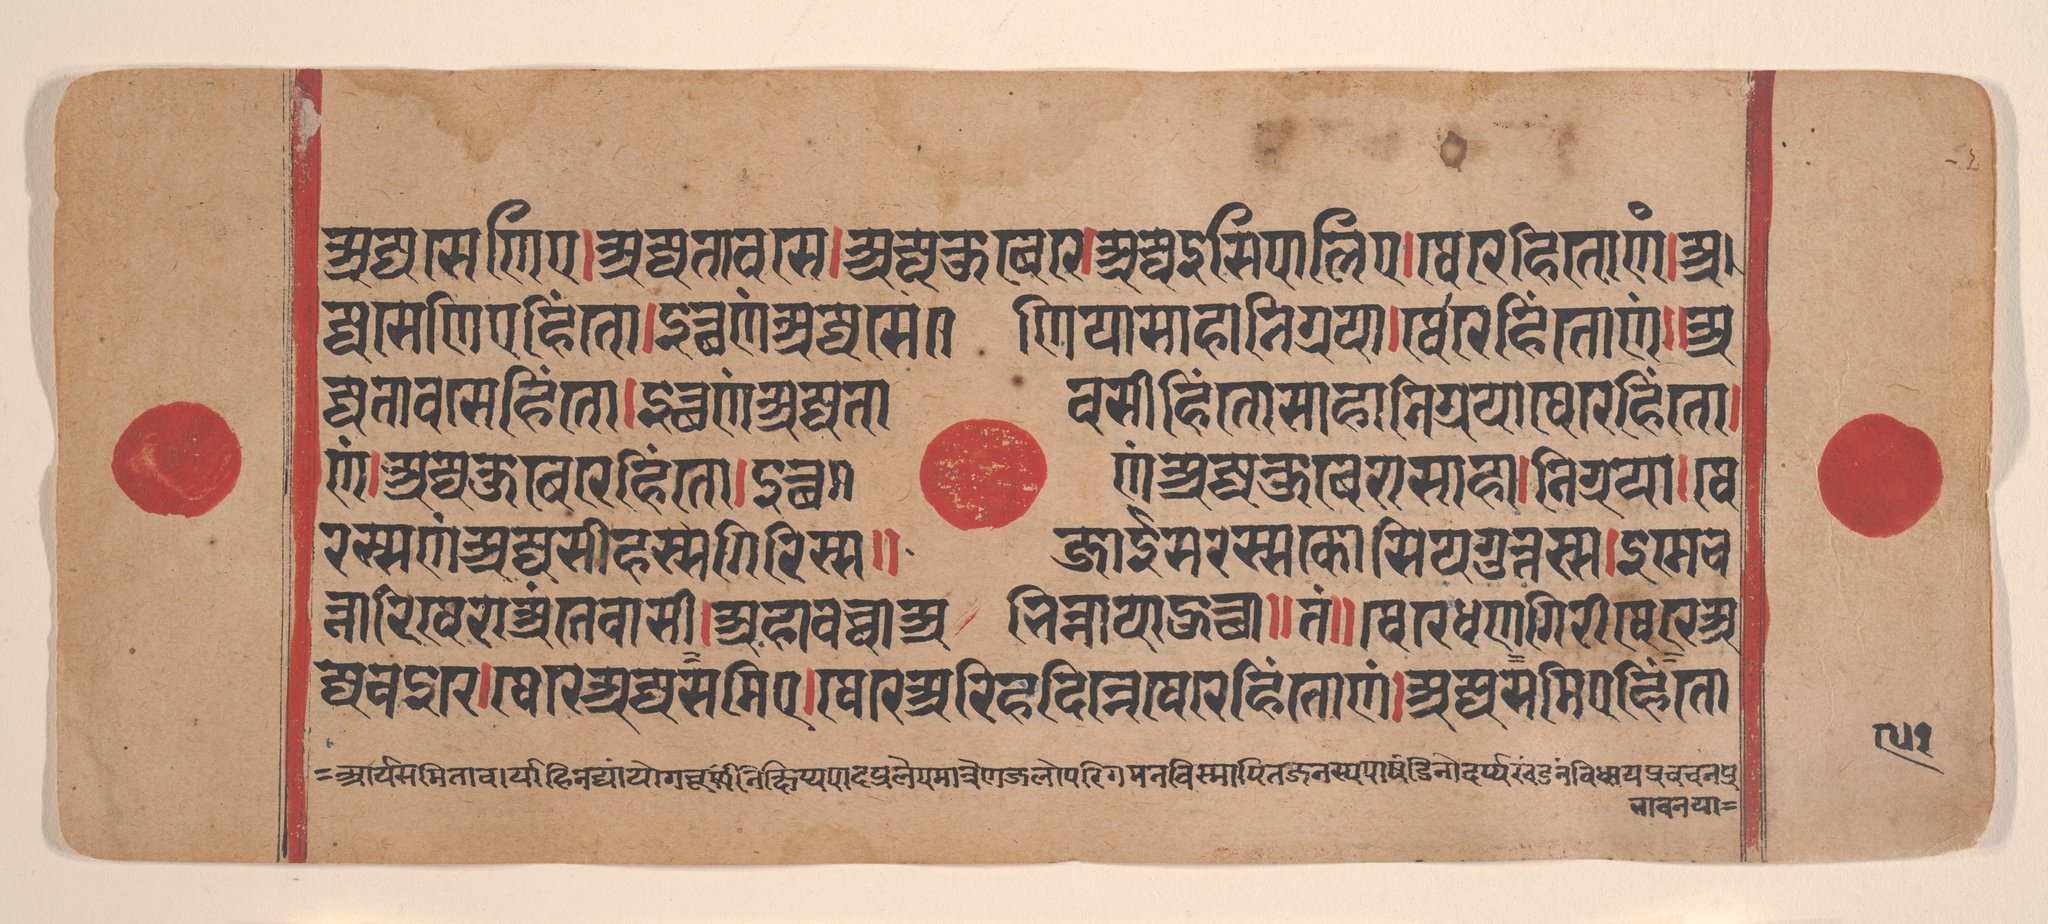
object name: folio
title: Page from a Dispersed Kalpa Sutra (Jain Book of Rituals)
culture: indian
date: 1401-1500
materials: gold, ink, paper, watercolor